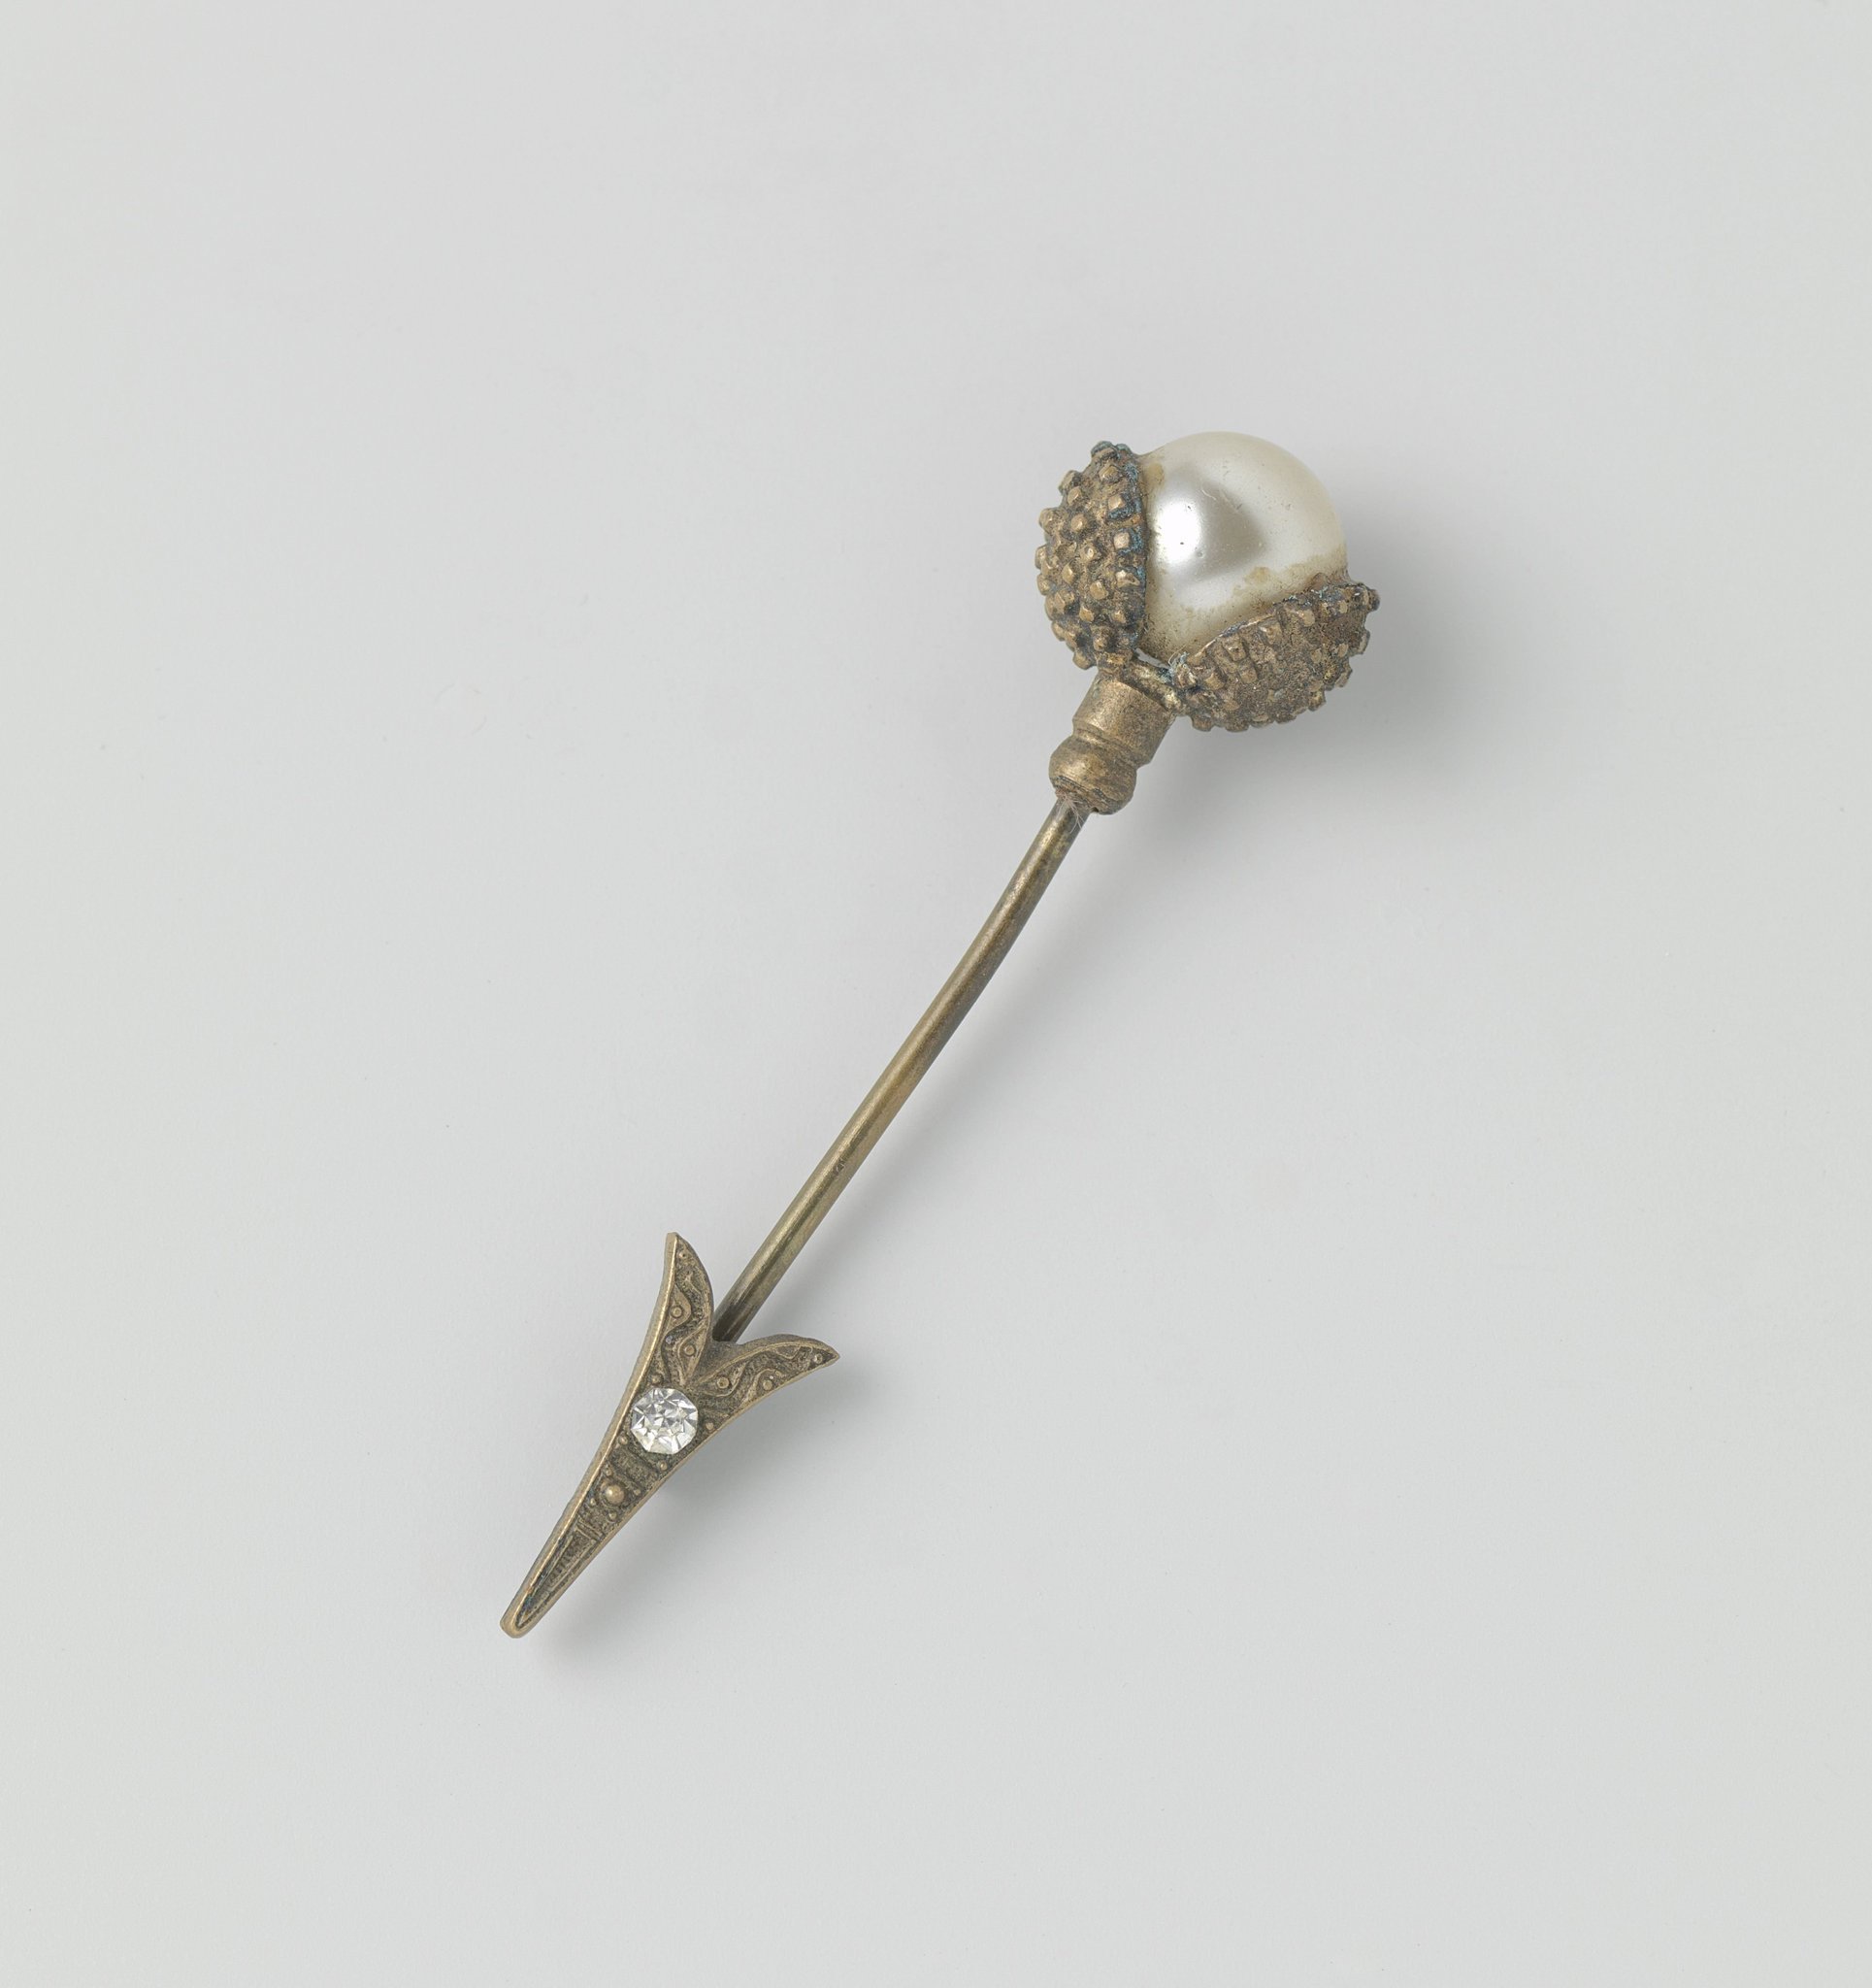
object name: hatpin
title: Hoedenspeld met pijlpunt en een knop van parelmoer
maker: Anonymous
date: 1920-1930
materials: copper, glass, mother of pearl, paste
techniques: forging, grinding, inlay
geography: netherlands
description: Hoedenspeld met pijlpunt, ingelegd met geslepen glas en een knop van ronde parelmoer, gevat in een opengesplitste bol van koper.